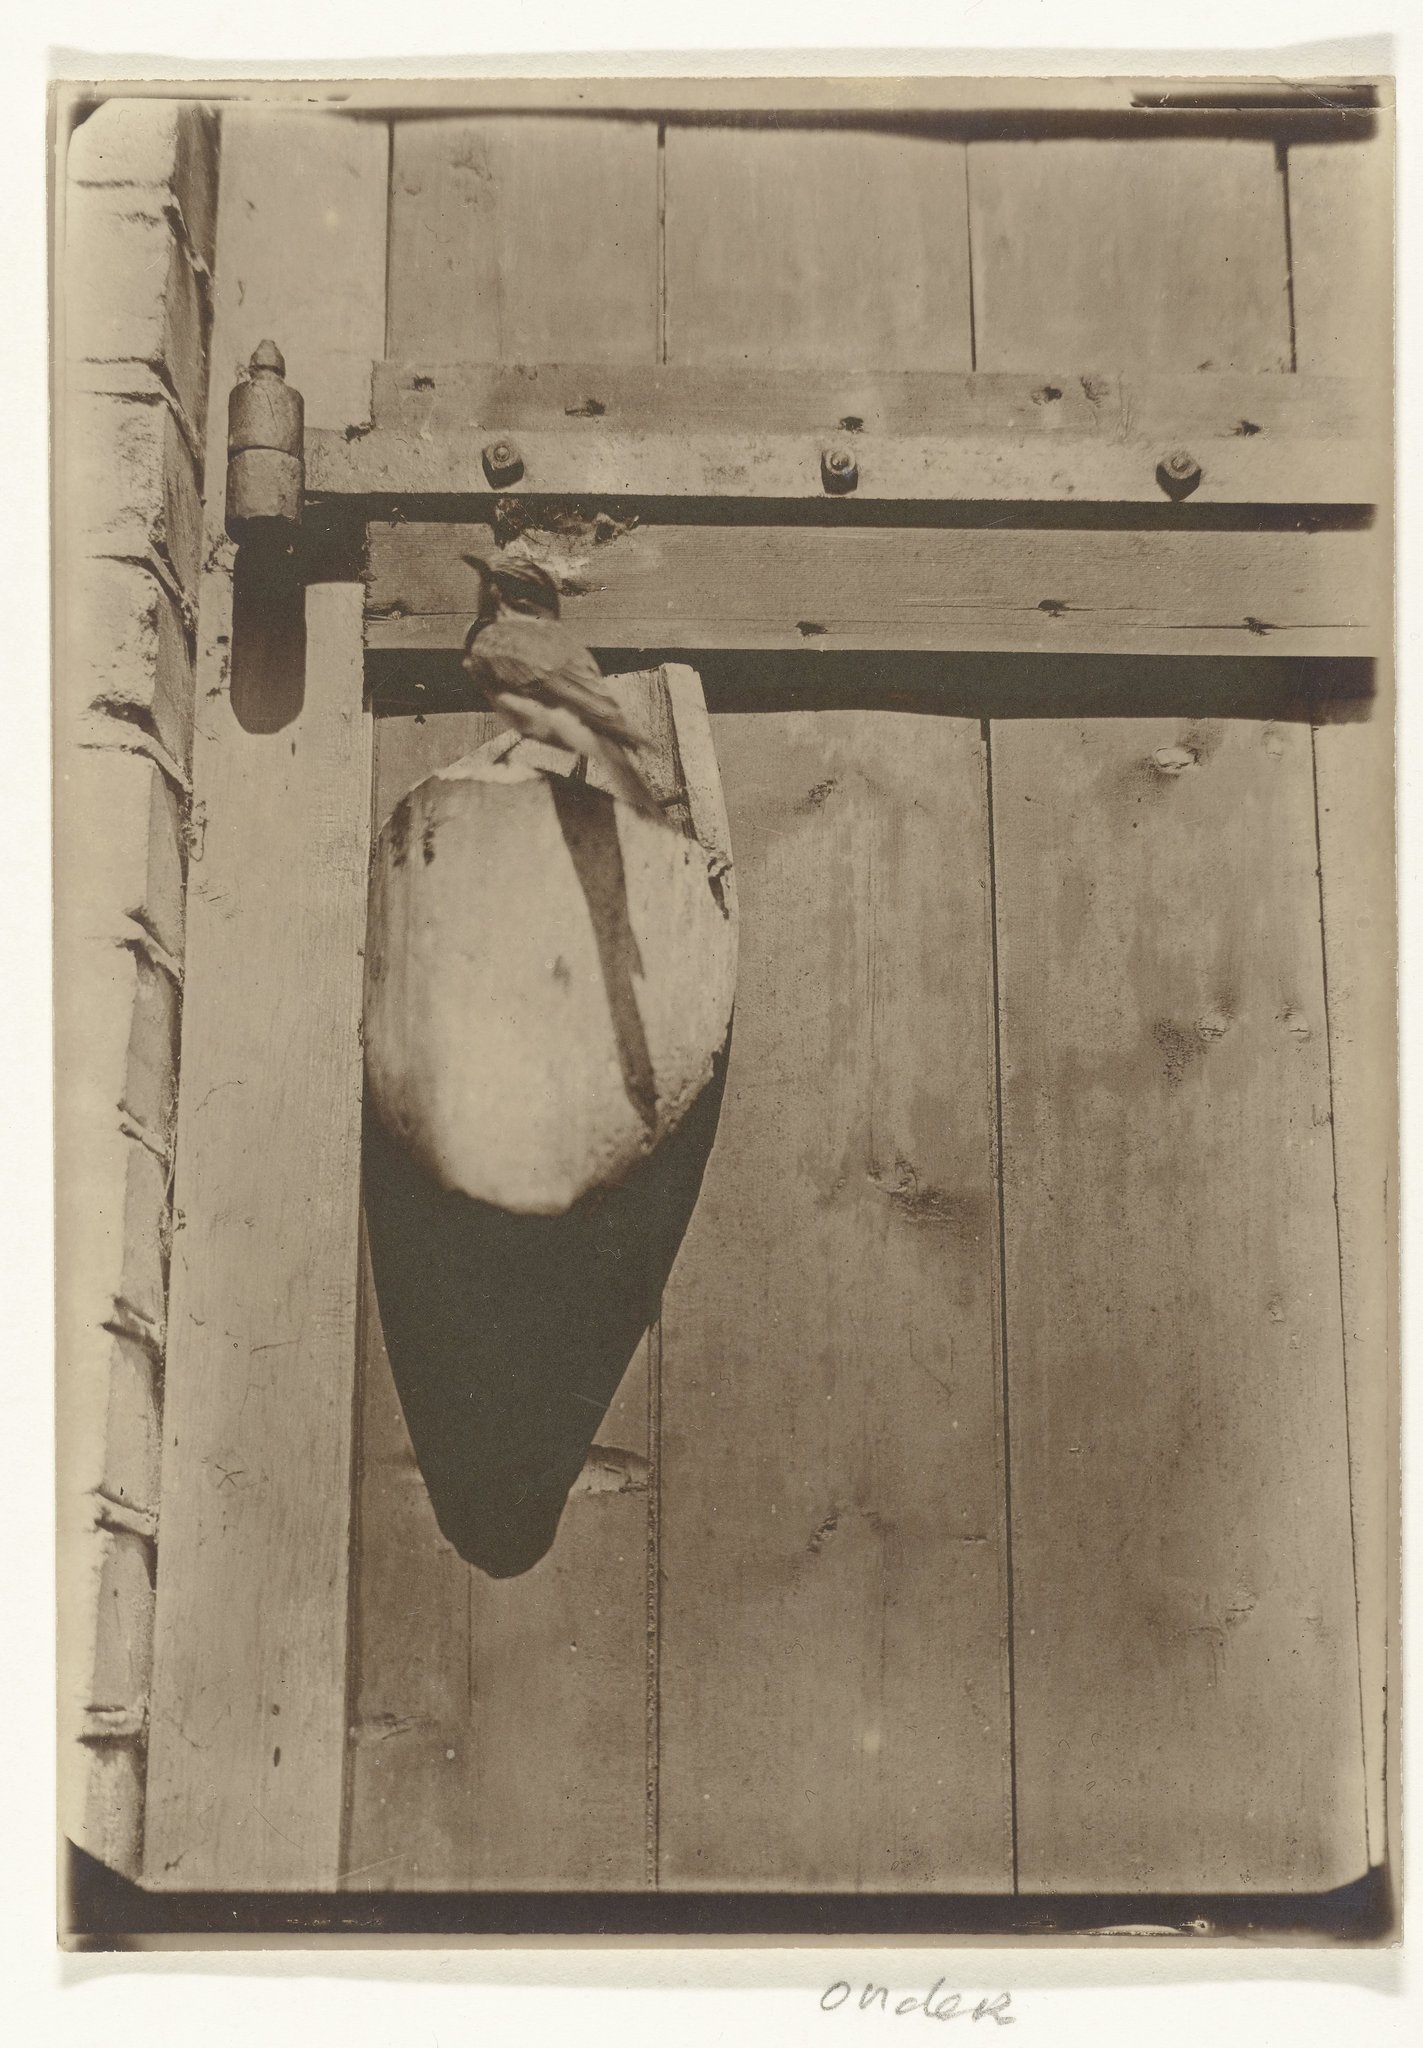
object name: photograph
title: Vogel zittend op een als nest dienende houten klomp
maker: richard tepe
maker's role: fotograaf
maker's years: 1864-1952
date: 1900-1930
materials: paper, photographic support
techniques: gelatin silver print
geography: netherlands